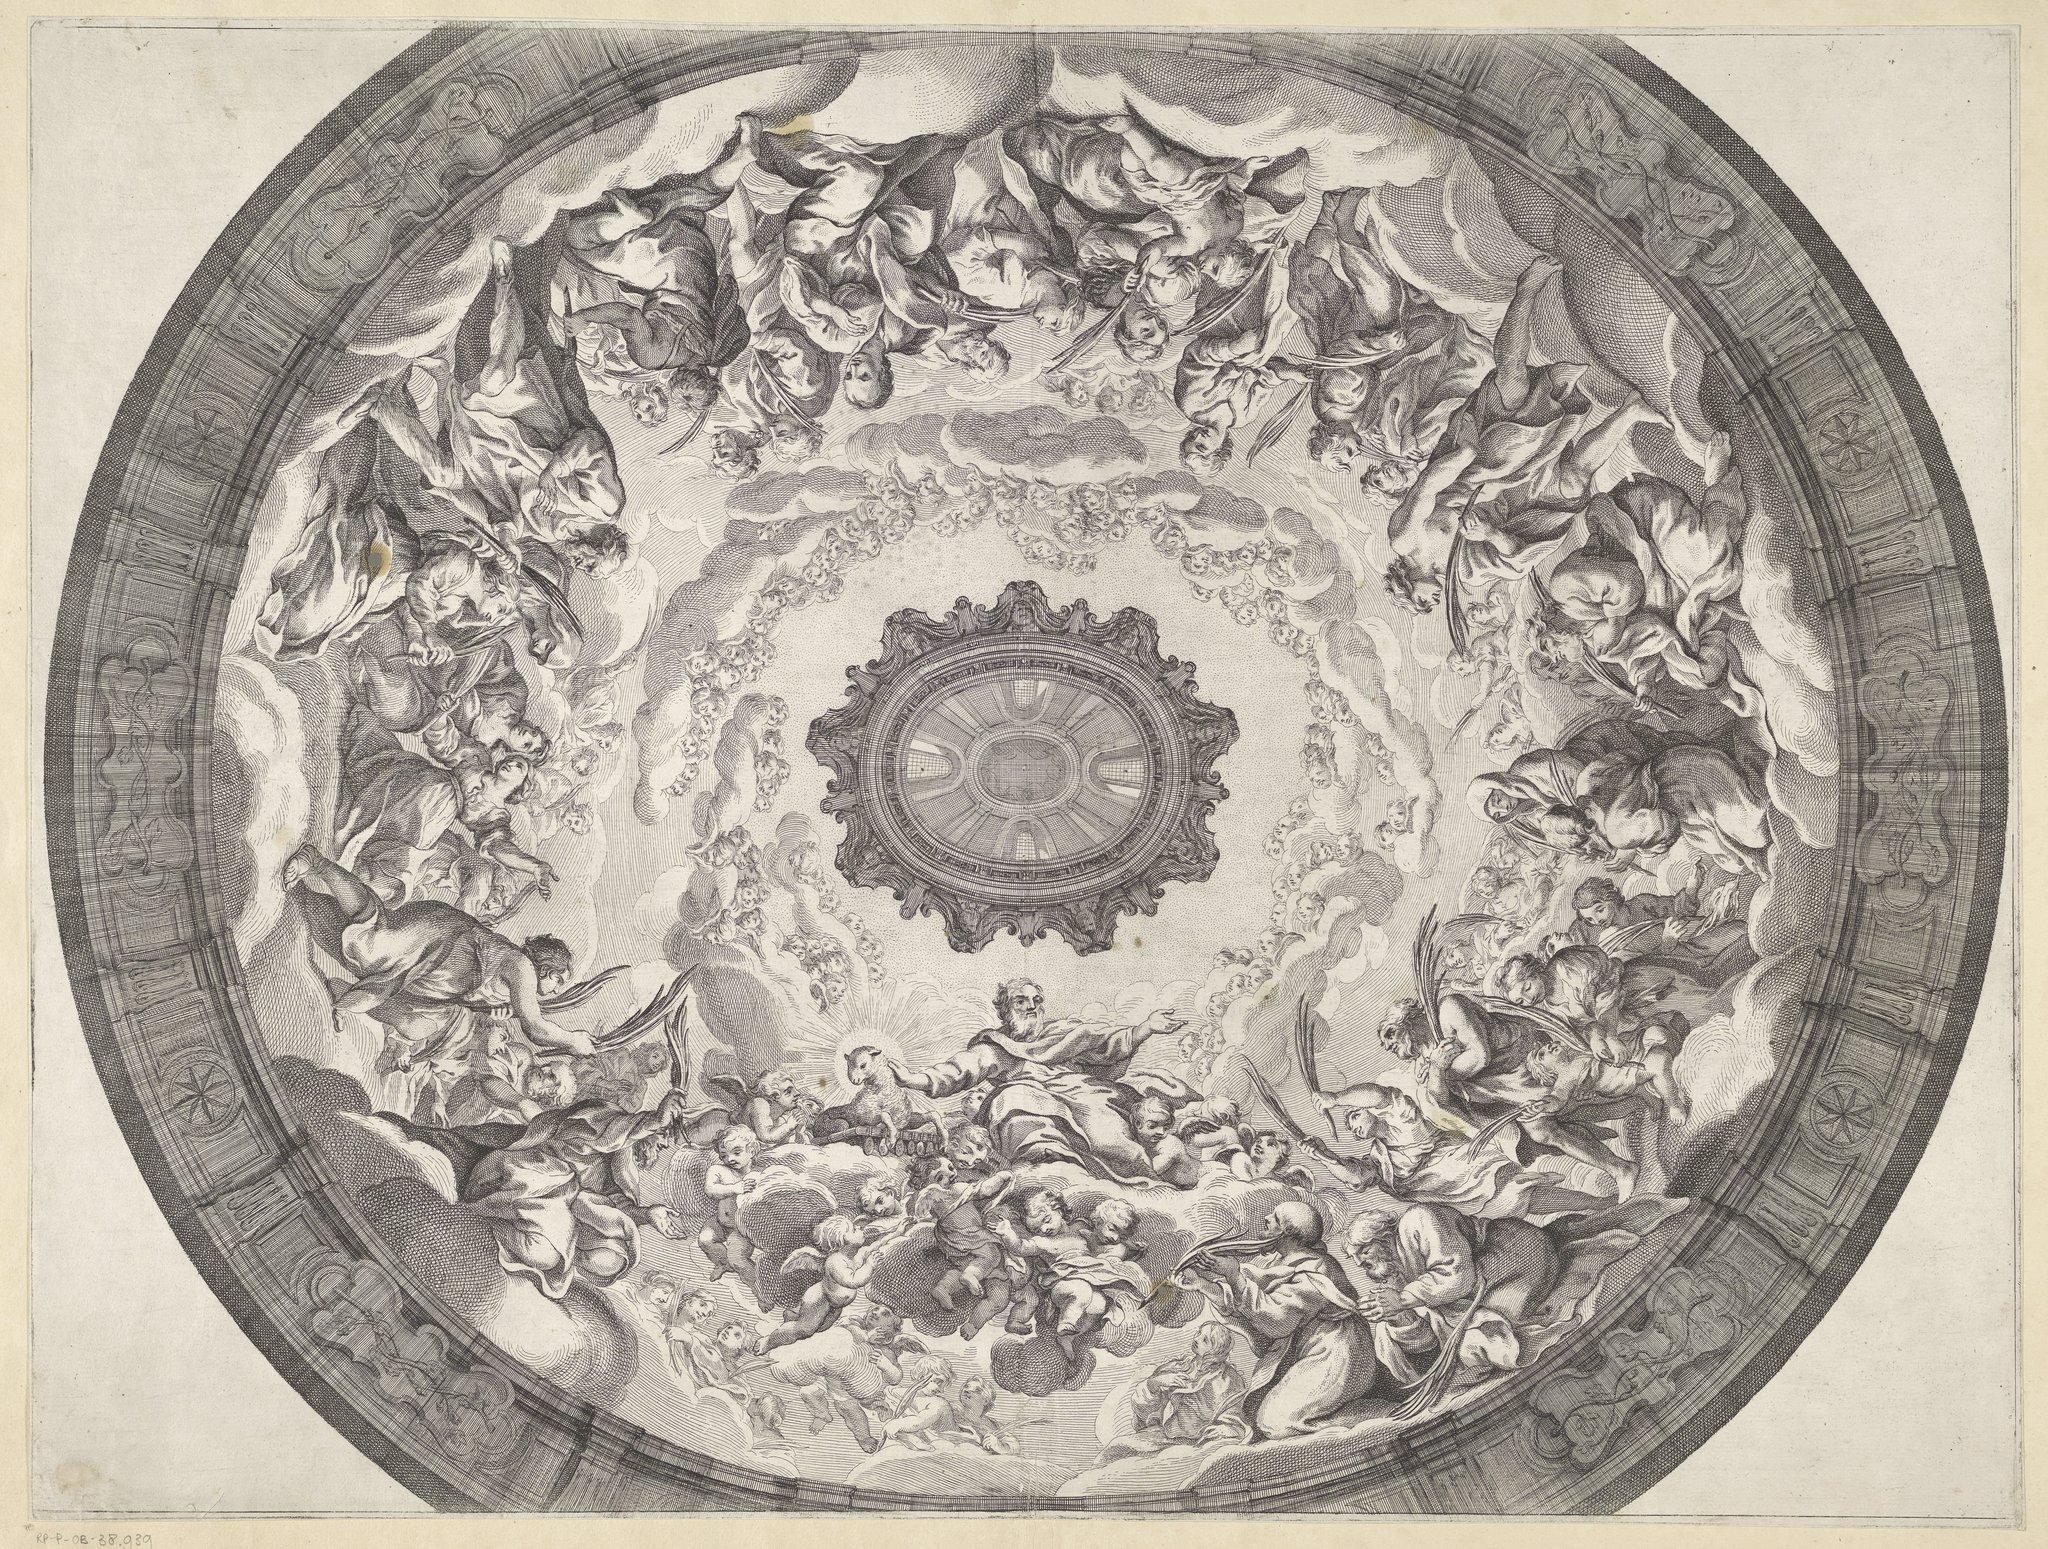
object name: print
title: Koepeldecoraties in de Sint-Pietersbasiliek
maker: francesco faraone aquila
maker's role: print maker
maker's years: 1676-1740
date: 1686-1740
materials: paper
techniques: etching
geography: italy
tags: lamb bearing cross or banner, 'agnus dei' ~ symbol of christ (+ variant), martyr(s) (often with palm-branches) - qq - female martyr, other architectural details (cupola), martyr(s) (often with palm-branches), cupids: 'amores', 'amoretti', 'putti'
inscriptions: collector's mark: Lugt 240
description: Koepeldecoratie met martelaren en putti die het Lam Gods aanbidden, in de koepel van de kapel van San Sebastiano in de Sint-Pietersbasiliek in het Vaticaan.